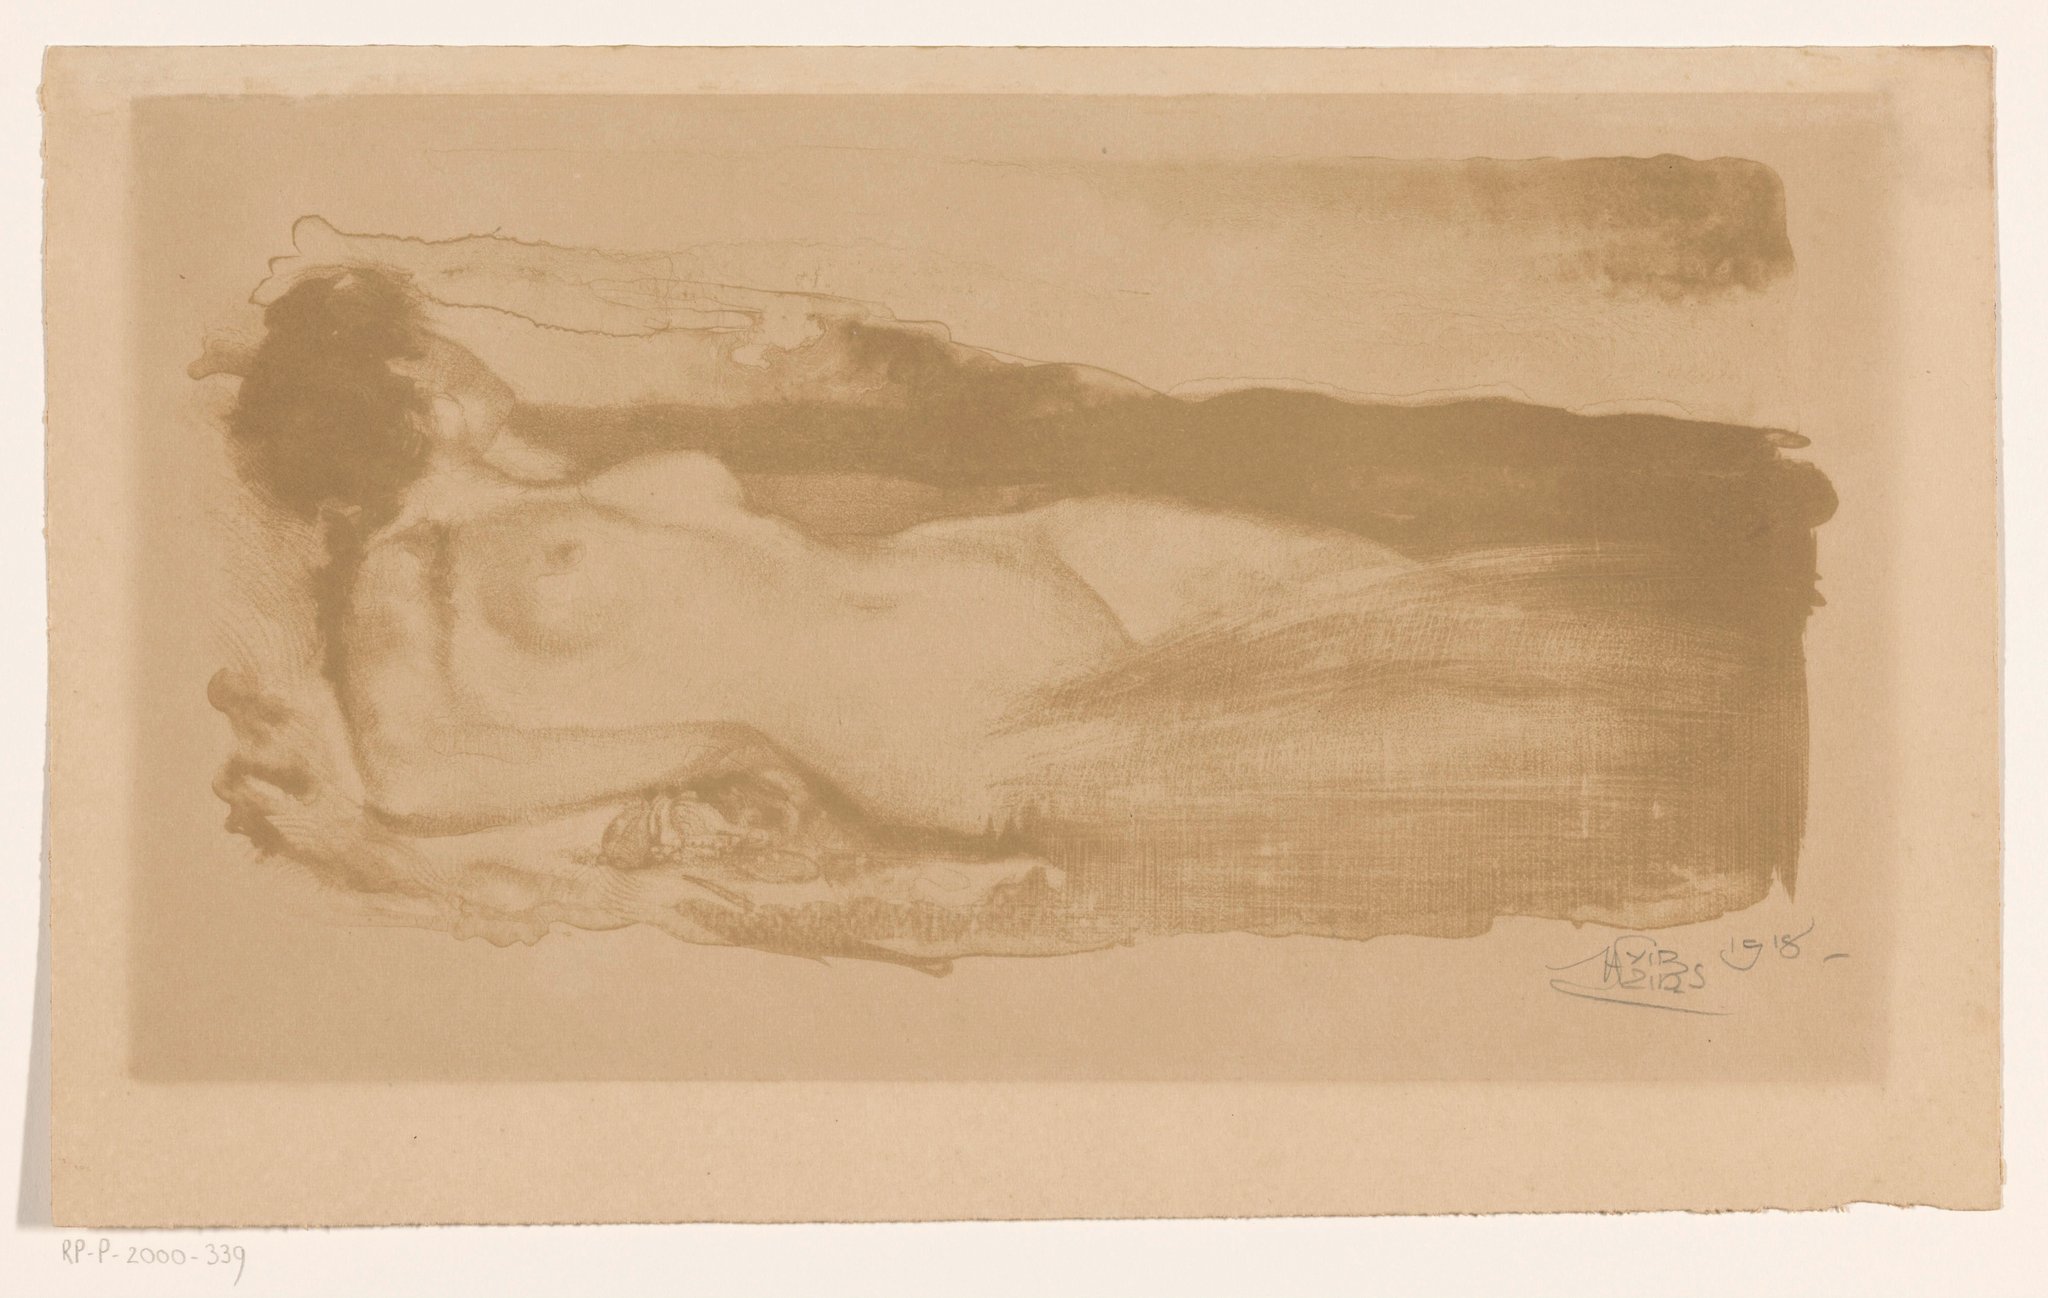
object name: print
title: Liggende naakte vrouw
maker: huib luns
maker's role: draughtsman, print maker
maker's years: 1881-1942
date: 1918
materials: paper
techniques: lithograph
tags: woman (showing herself) undressed, quasi-nude, lying figure - aa - female human figure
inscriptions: collector's mark: Lugt 2228, collector's mark: Lugt 2760